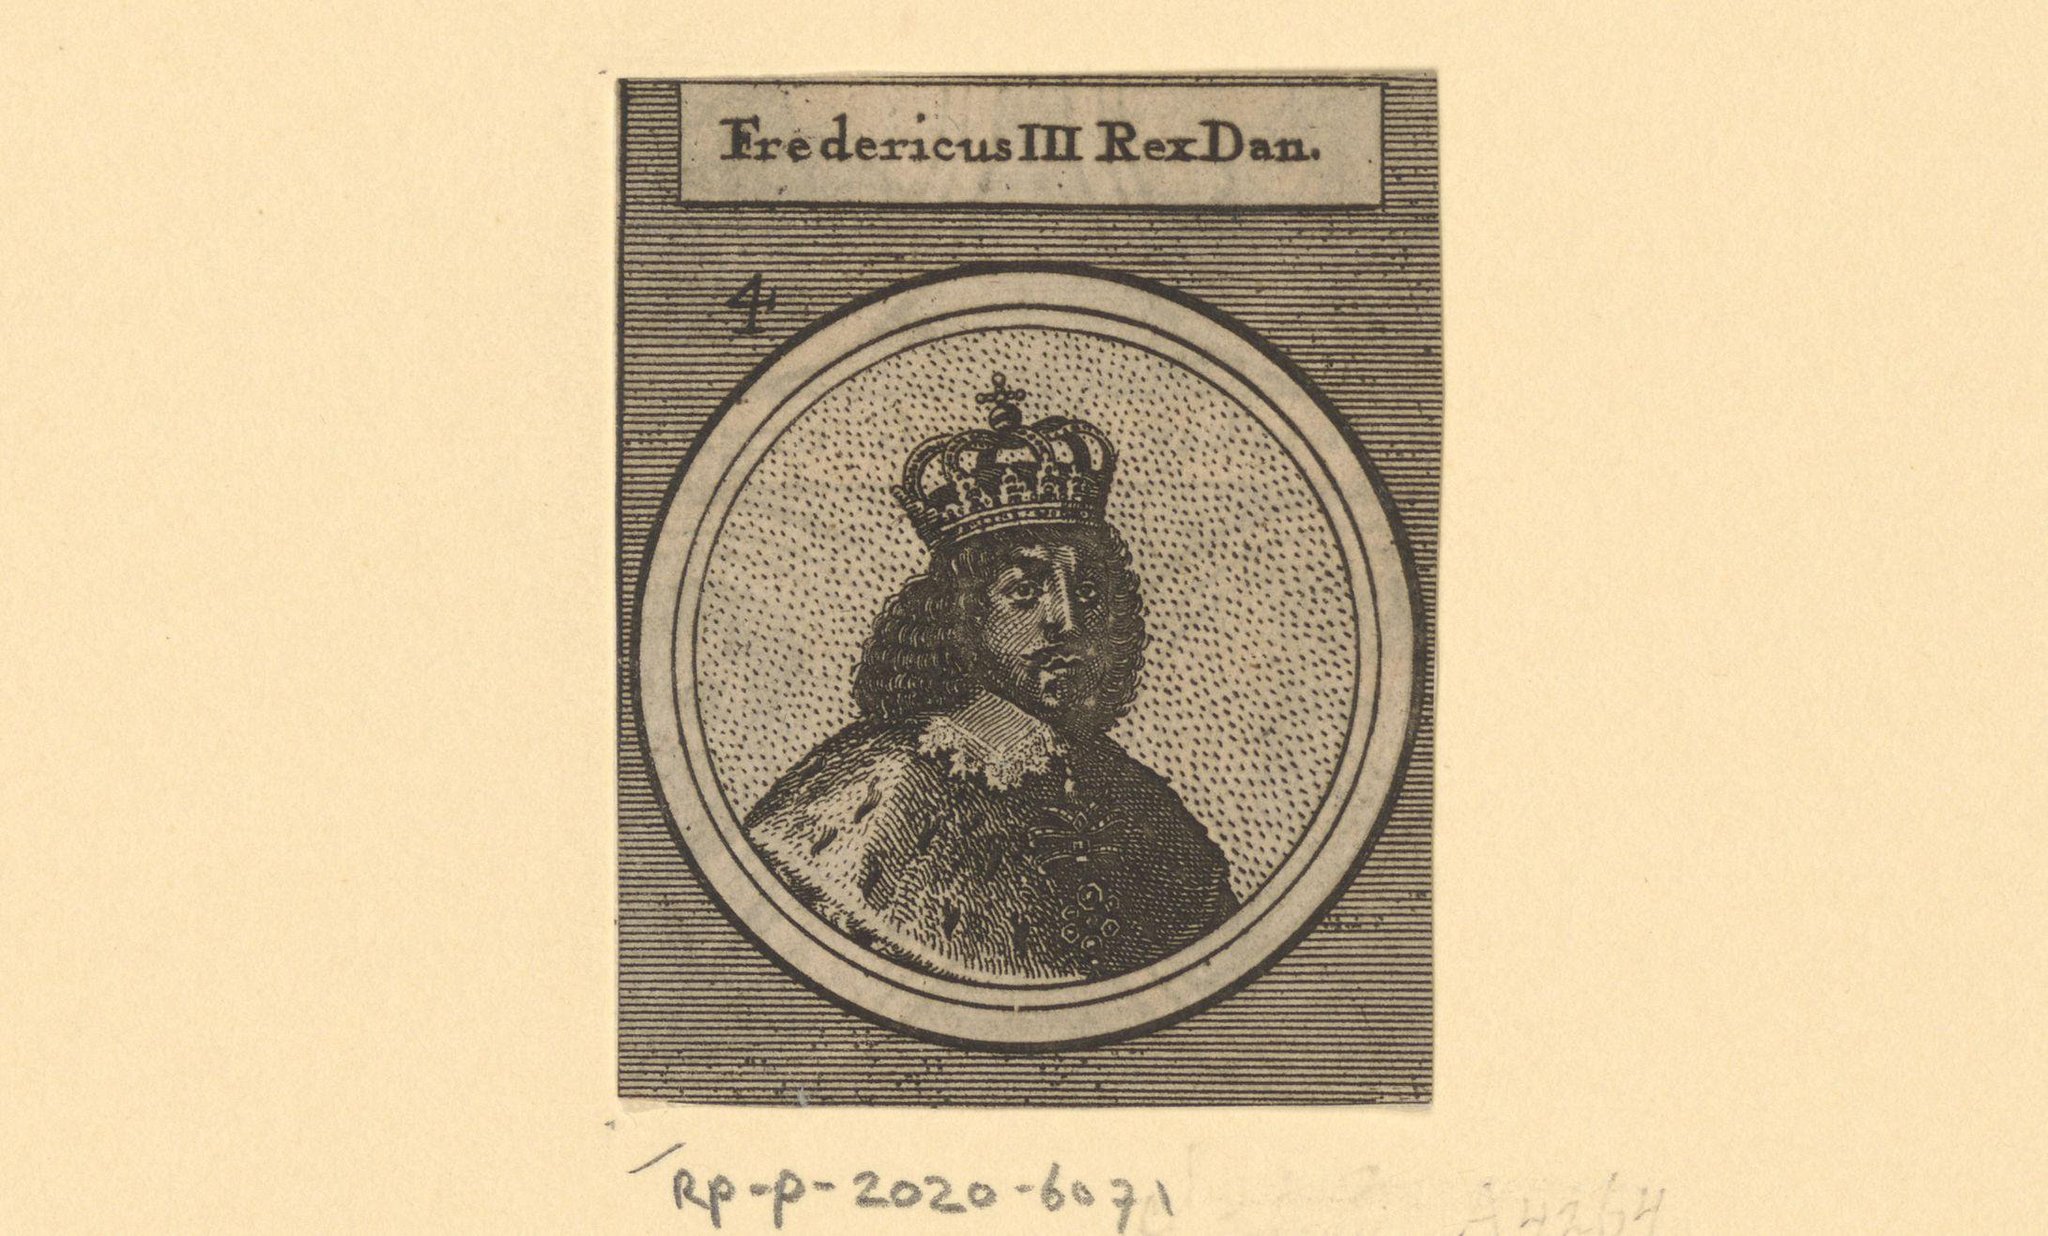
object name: print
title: Portret van Frederik III van Denemarken en Noorwegen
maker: Anonymous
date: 1698-1700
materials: paper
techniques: etching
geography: northern netherlands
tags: copenhagen (city), frederik iii (koning van denemarken en noorwegen), armour, historical persons, king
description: Prent mogelijk uit: Gottfried, Johann Ludwig. Historische Kronyck (...). Leiden: Pieter van der Aa, 1698-1700.